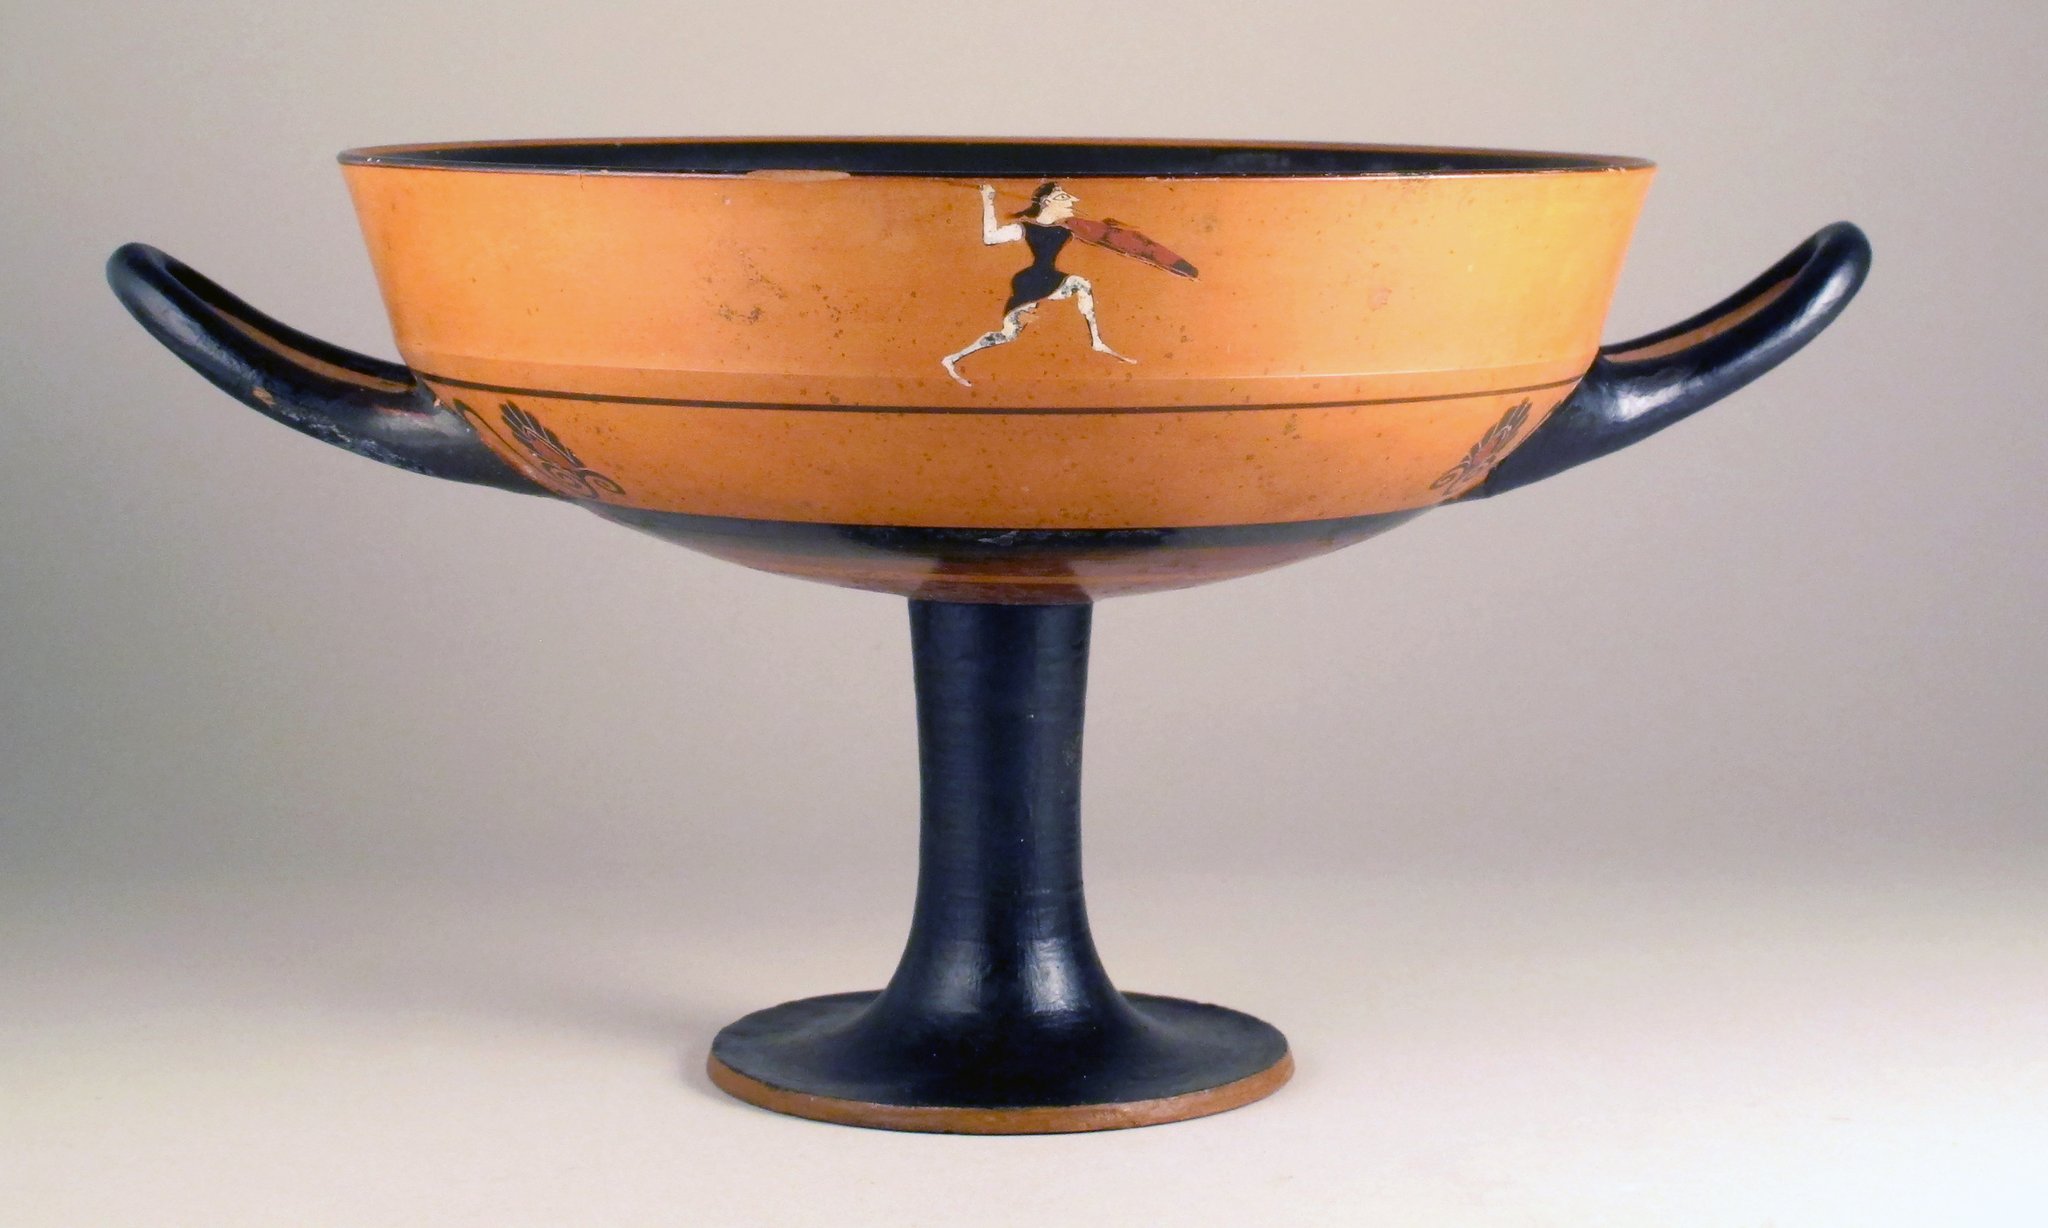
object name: kylix, lip cup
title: Terracotta kylix: lip-cup (drinking cup)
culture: greek, attic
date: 550-526 BCE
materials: terracotta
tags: amazons,warriors